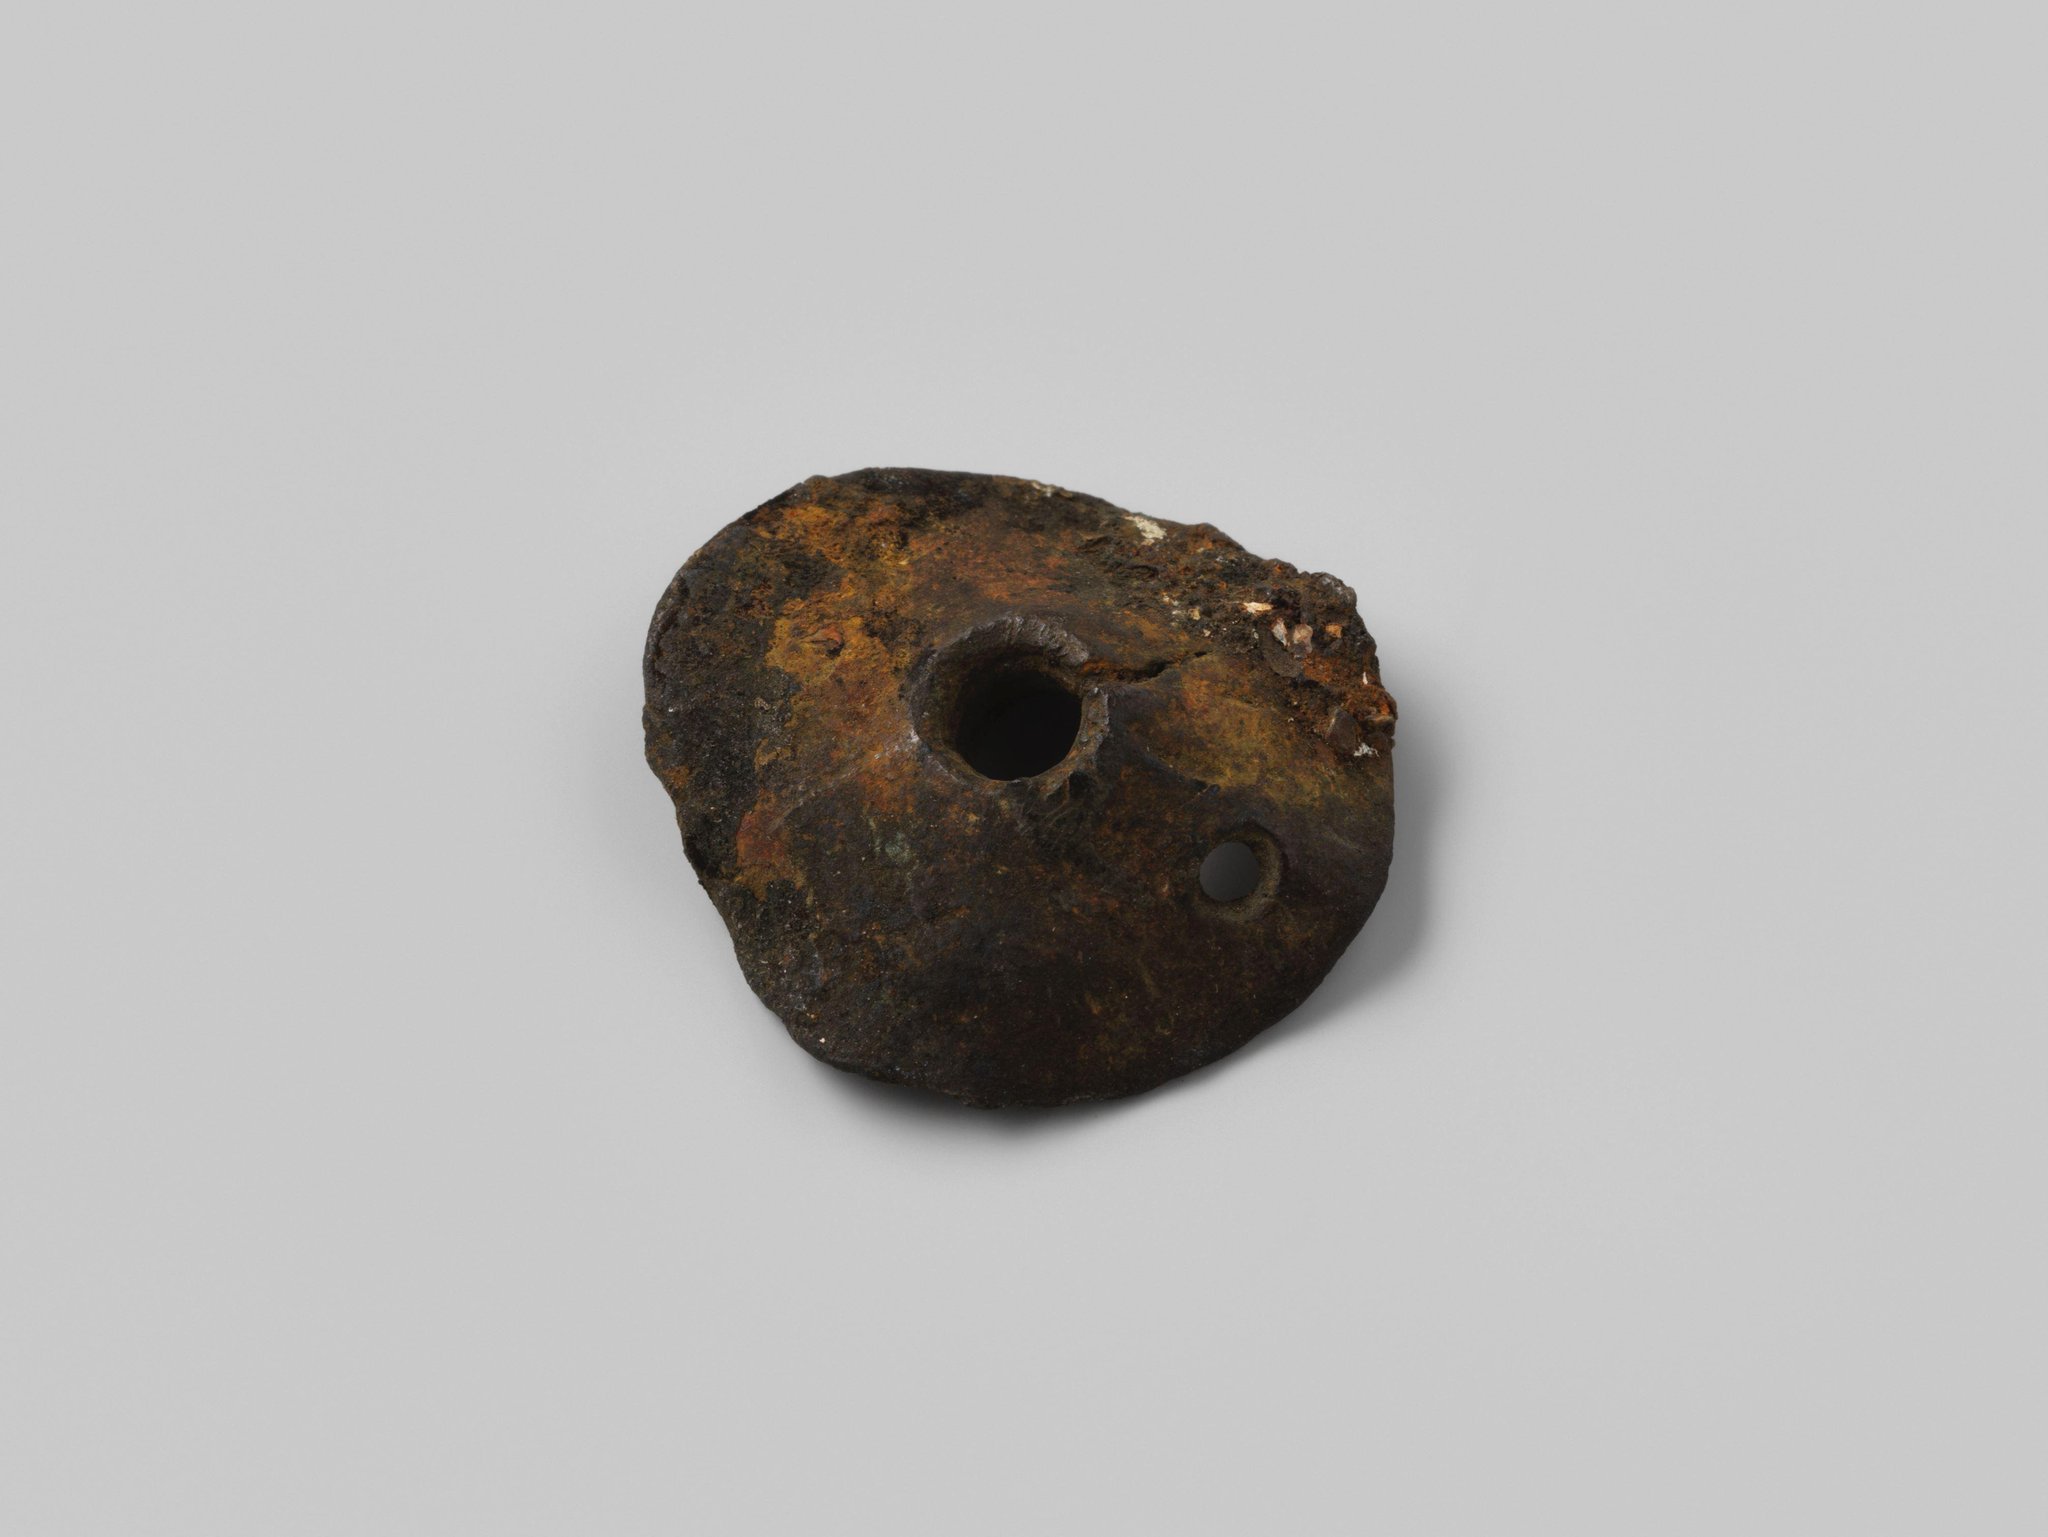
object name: fragment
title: Schijfvormig fragment uit het wrak van de Oost-Indiëvaarder Hollandia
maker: Anonymous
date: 1700-1743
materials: tin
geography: netherlands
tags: verenigde oostindische compagnie, hollandia (schip), annet